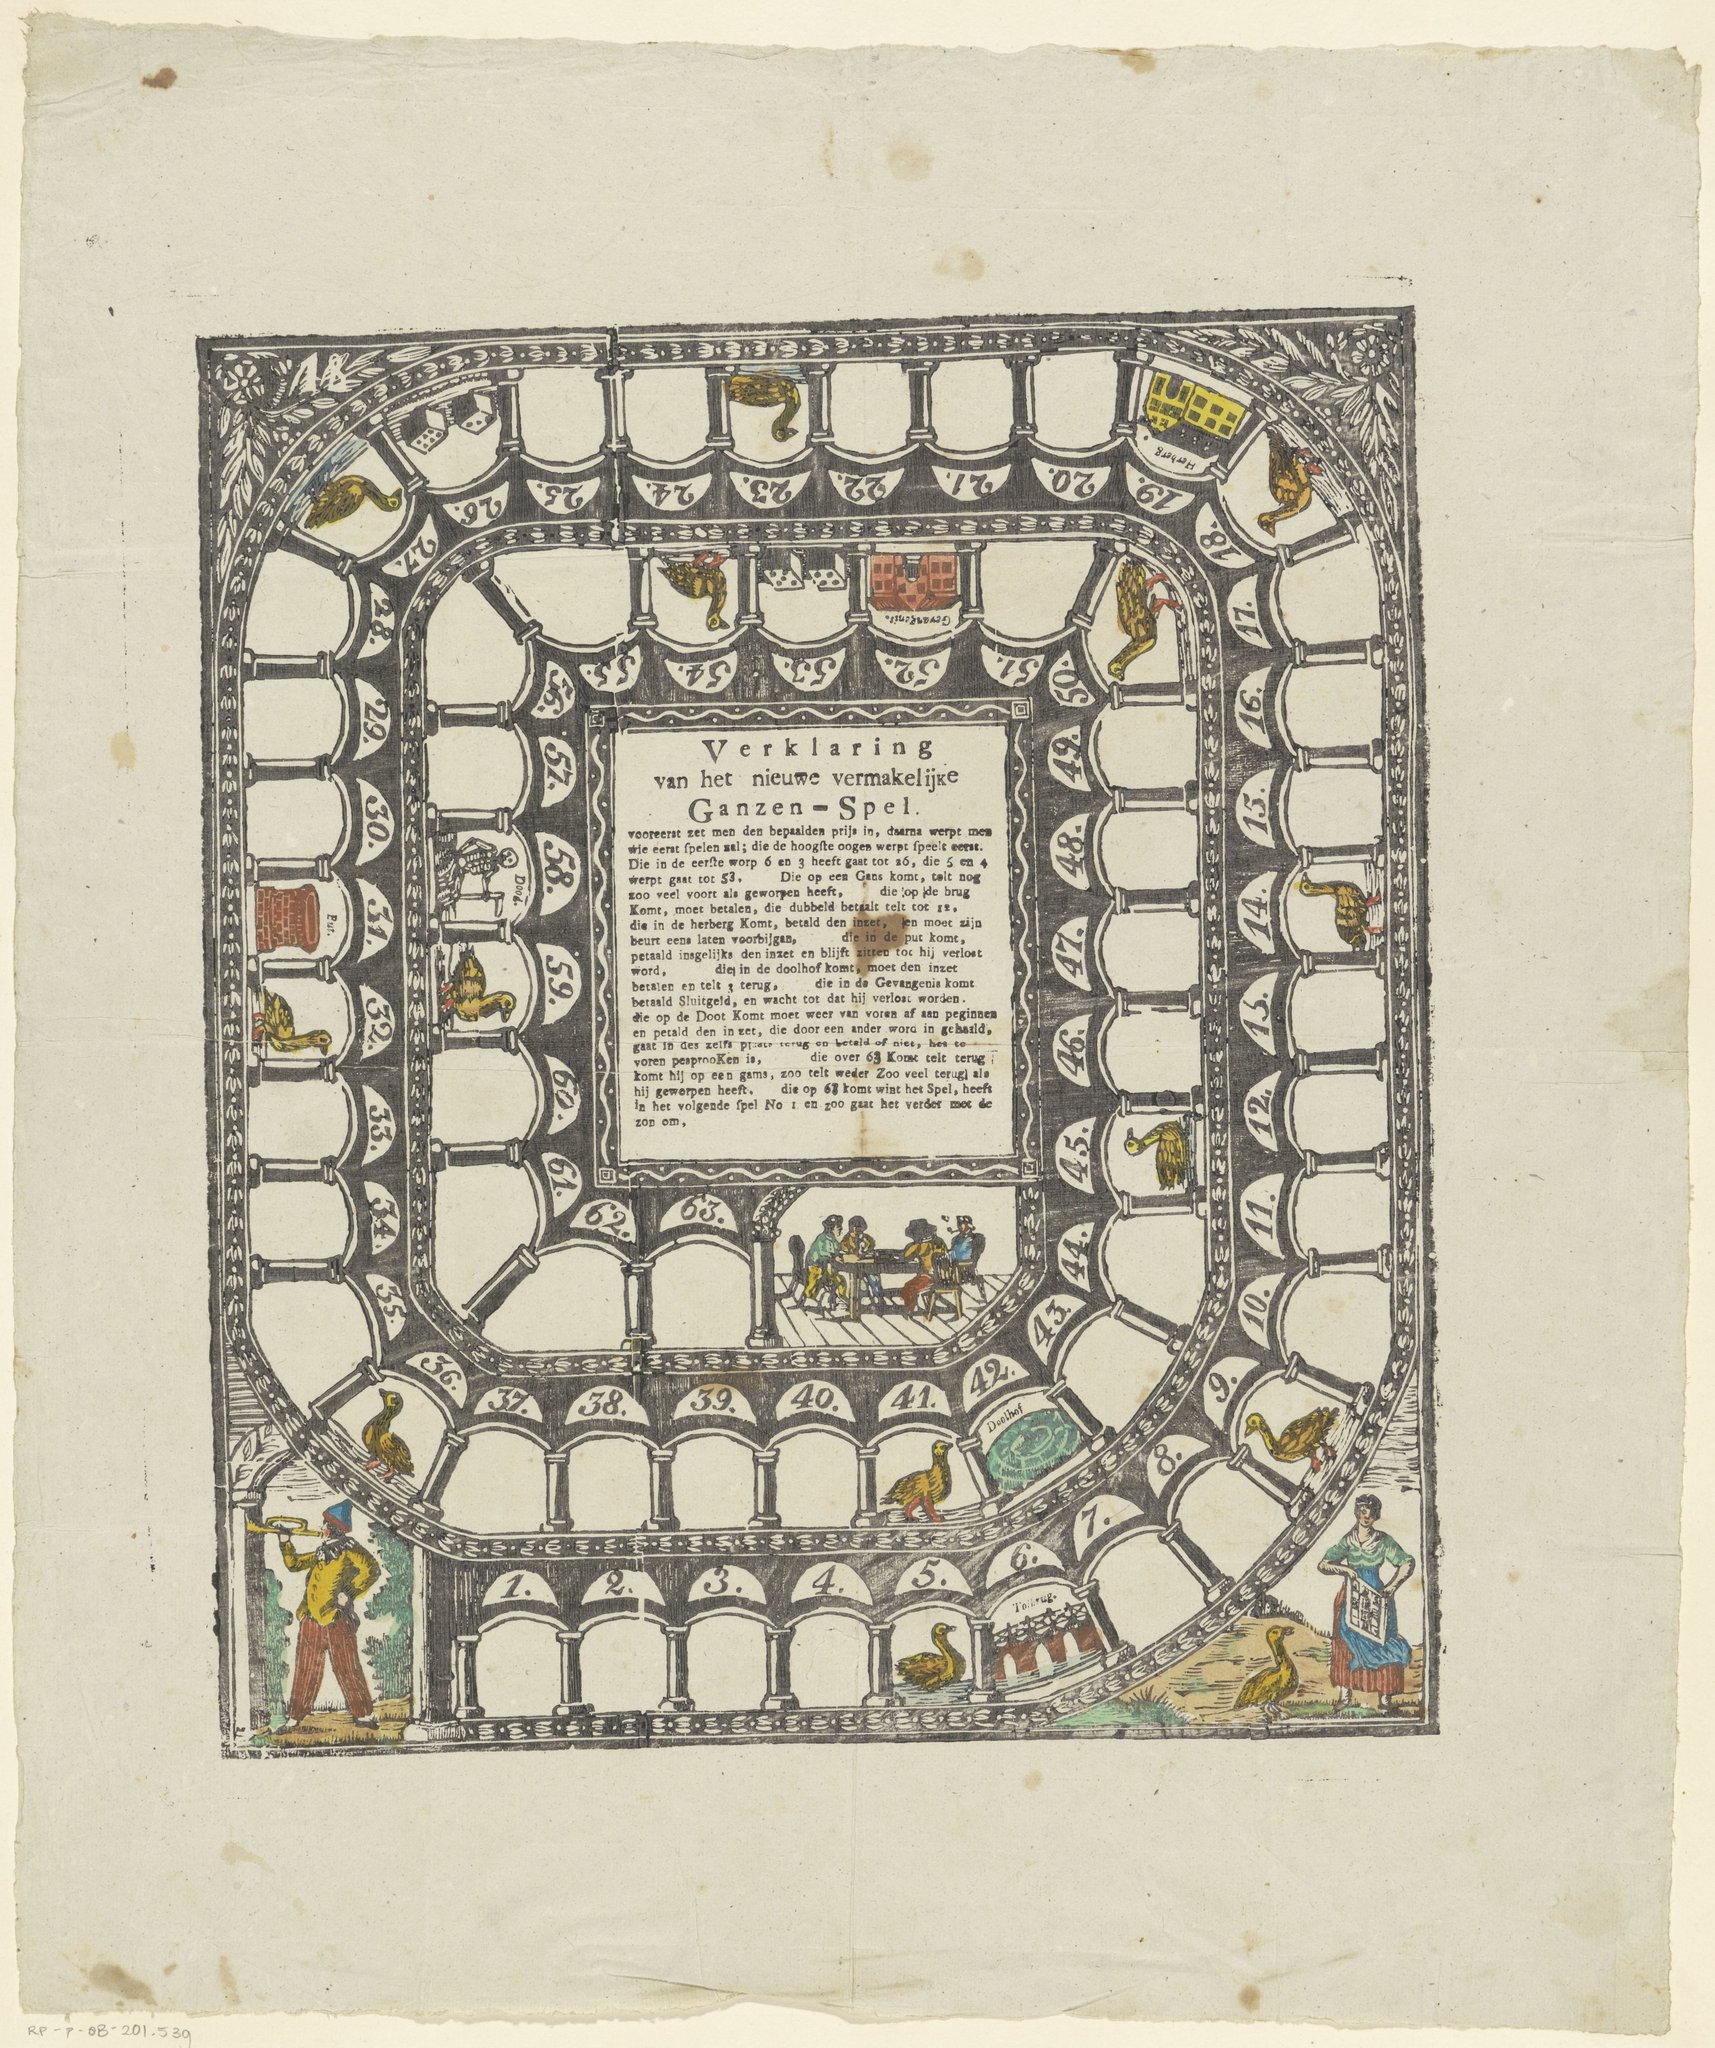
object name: game of goose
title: Het nieuwe vermakelijke ganzen-spel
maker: Anonymous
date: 1800-1900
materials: paper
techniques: colour, letterpress printing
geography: netherlands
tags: goose-game, board-games of chance, board-games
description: Ganzenbordspel met vakjes genummerd van 1 tot en met 63. In enkele vakjes, die van elkaar gescheiden worden door zuilen die halfronde bogen dragen, voorstellingen van ganzen. In het grote centrale vak de spelregels in het Nederlands.